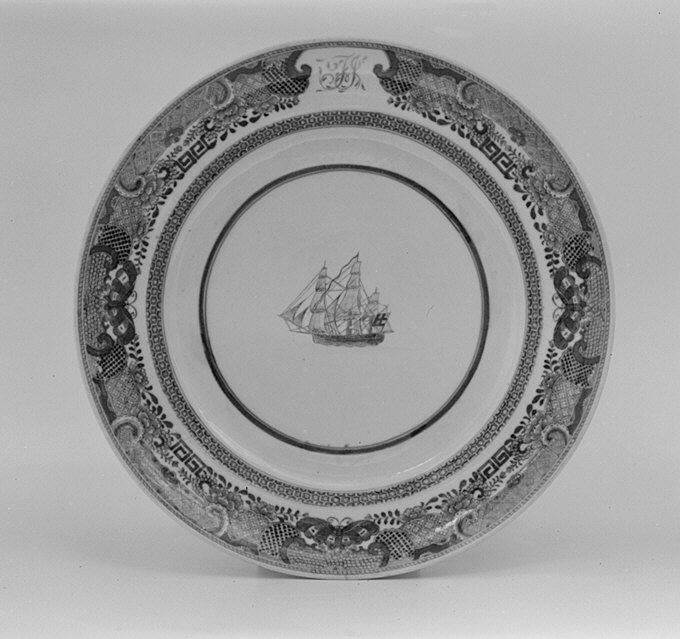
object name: plate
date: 1801-1833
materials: hard paste porcelain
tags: ships